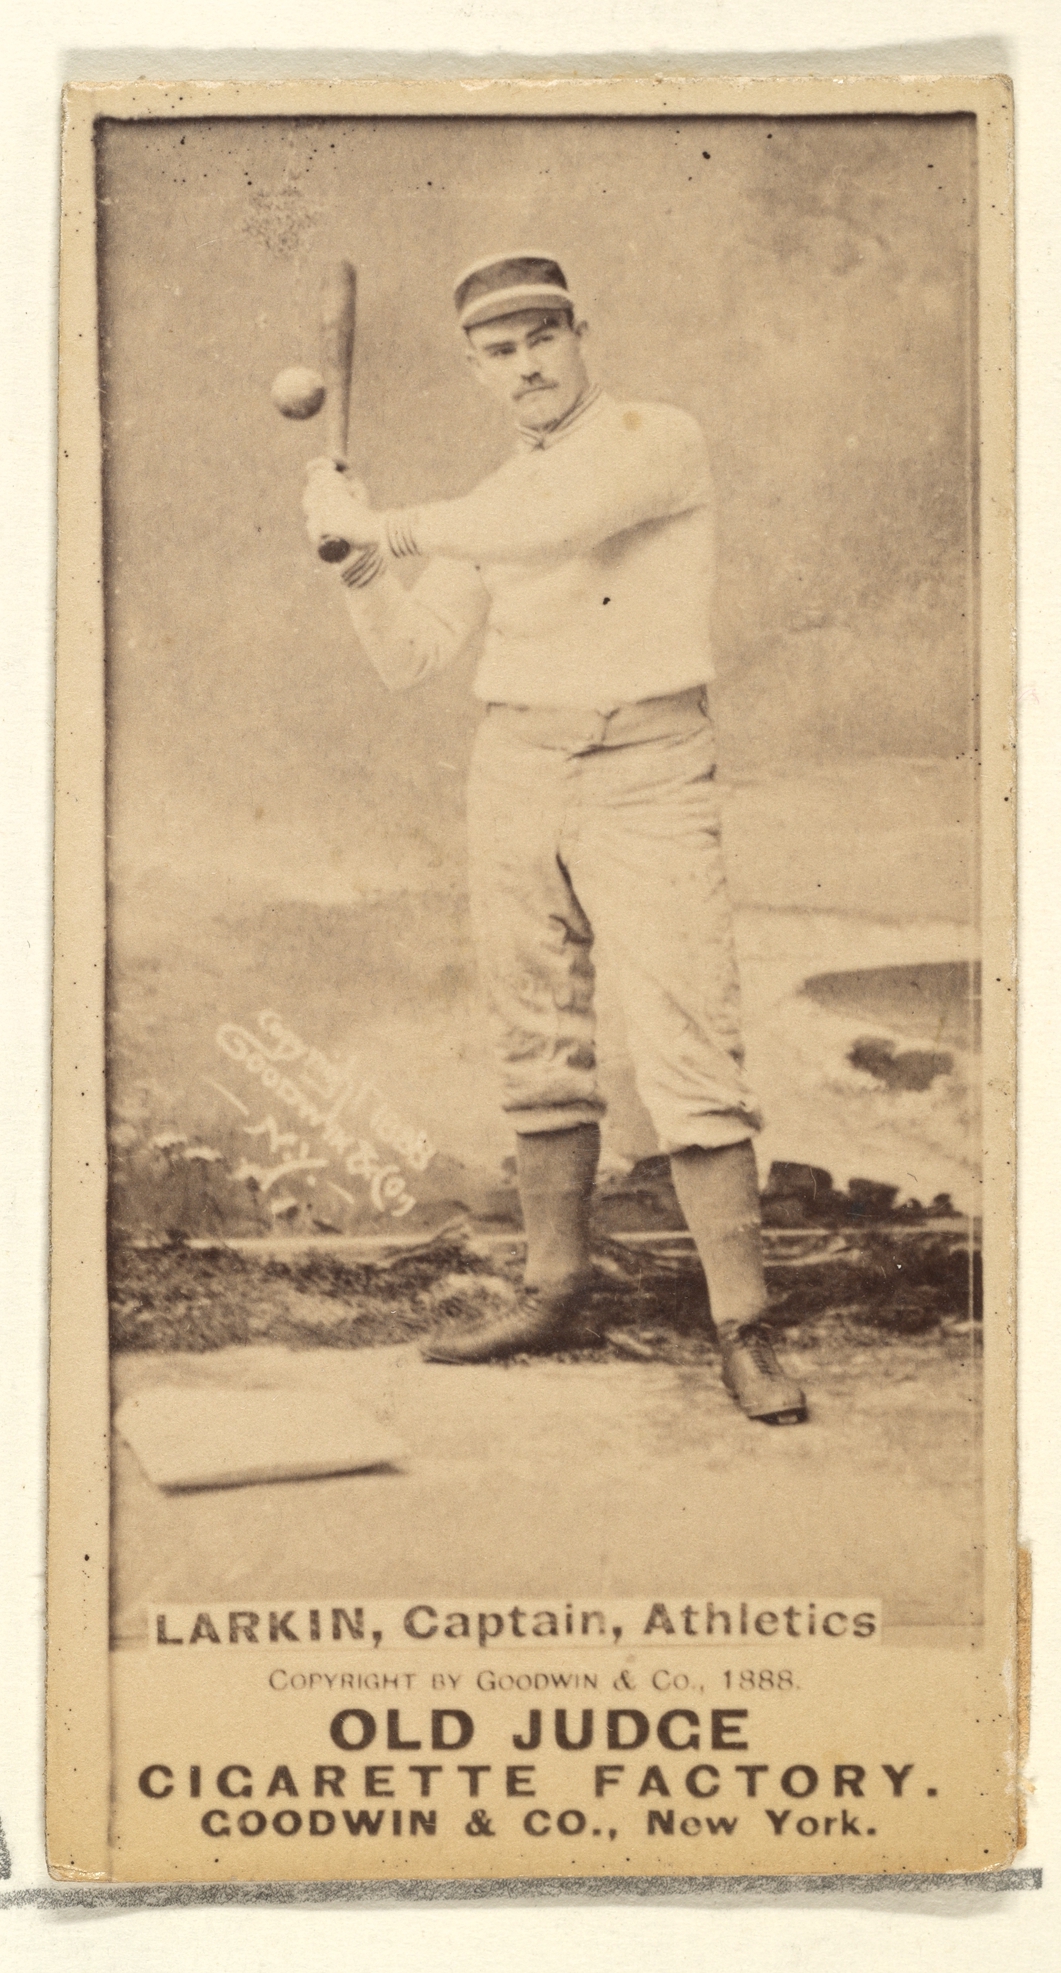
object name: baseball card, photograph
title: Larkin, Captain, Philadelphia Athletics, from the Old Judge series (N172) for Old Judge Cigarettes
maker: goodwin & company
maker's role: publisher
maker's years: 1850-1950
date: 1888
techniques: albumen silver print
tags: men,portraits,baseball,athletes